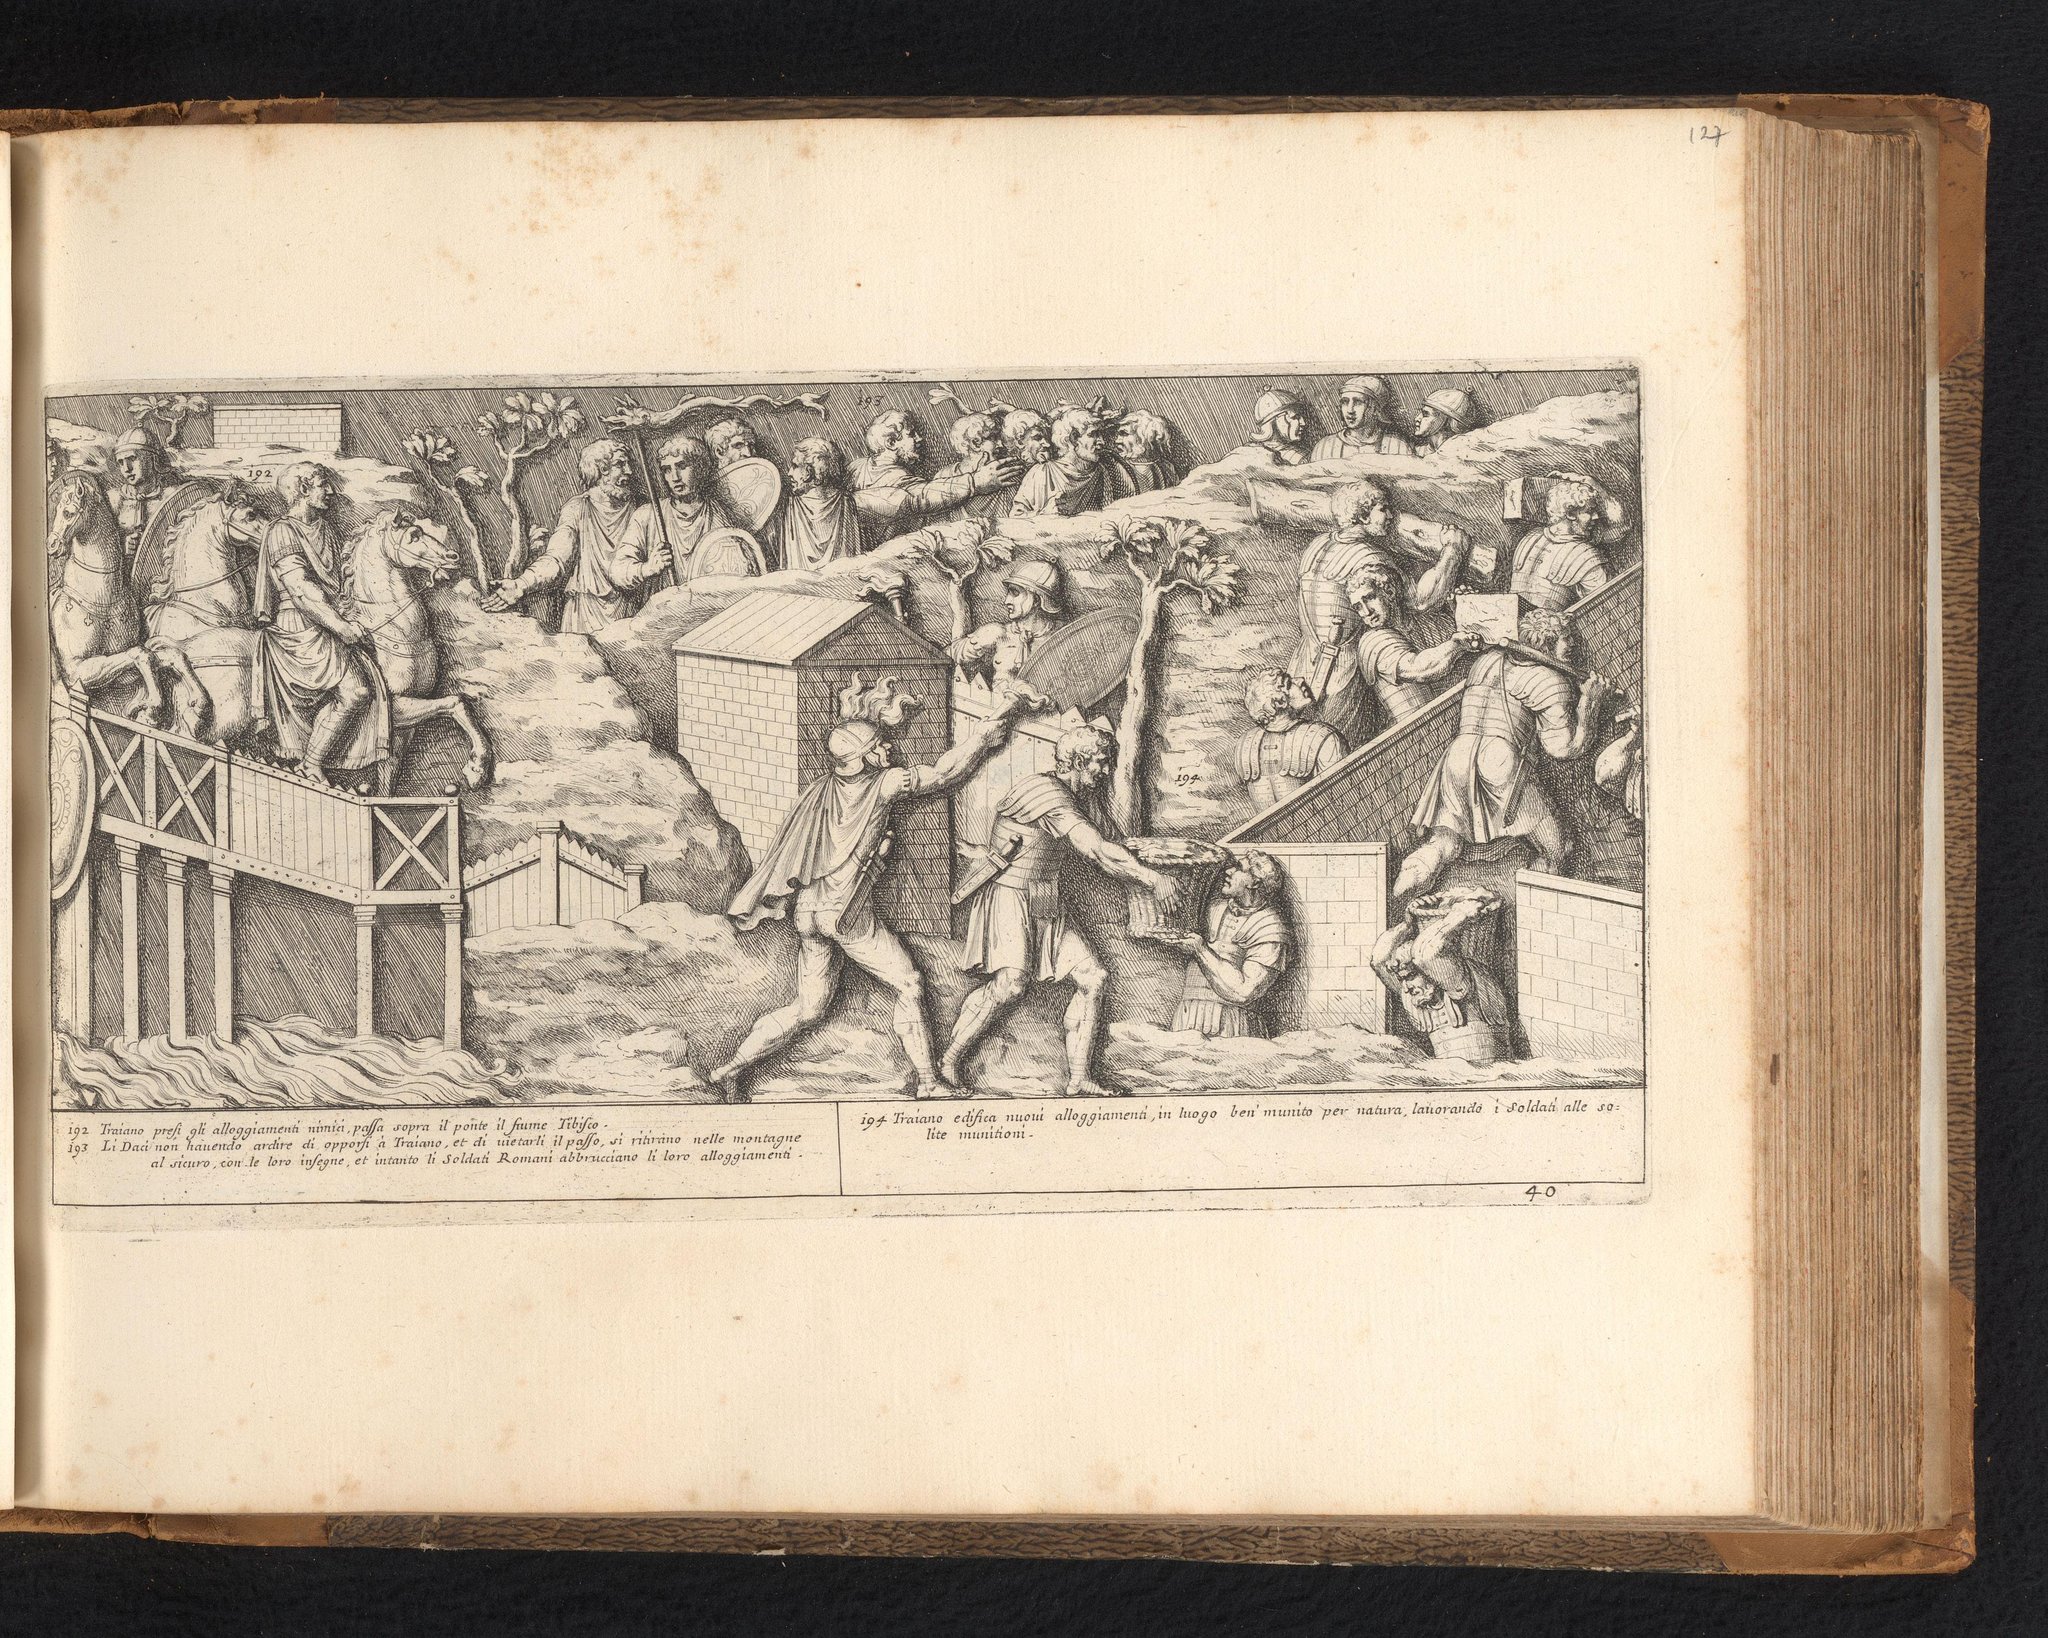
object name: print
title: Zuil van Trajanus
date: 1637-1691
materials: paper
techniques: etching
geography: france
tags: triumphal column with helical friezes, piece of sculpture, reproduction of a piece of sculpture, the soldier; the soldier's life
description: Detail van het spiraalvormige gebeeldhouwde fries op de Zuil van Trajanus. Het fries toont de oorlogen tussen de Romeinen en de Daciërs. Verklarende nummers in de ondermarge. Prent maakt deel uit van een album.